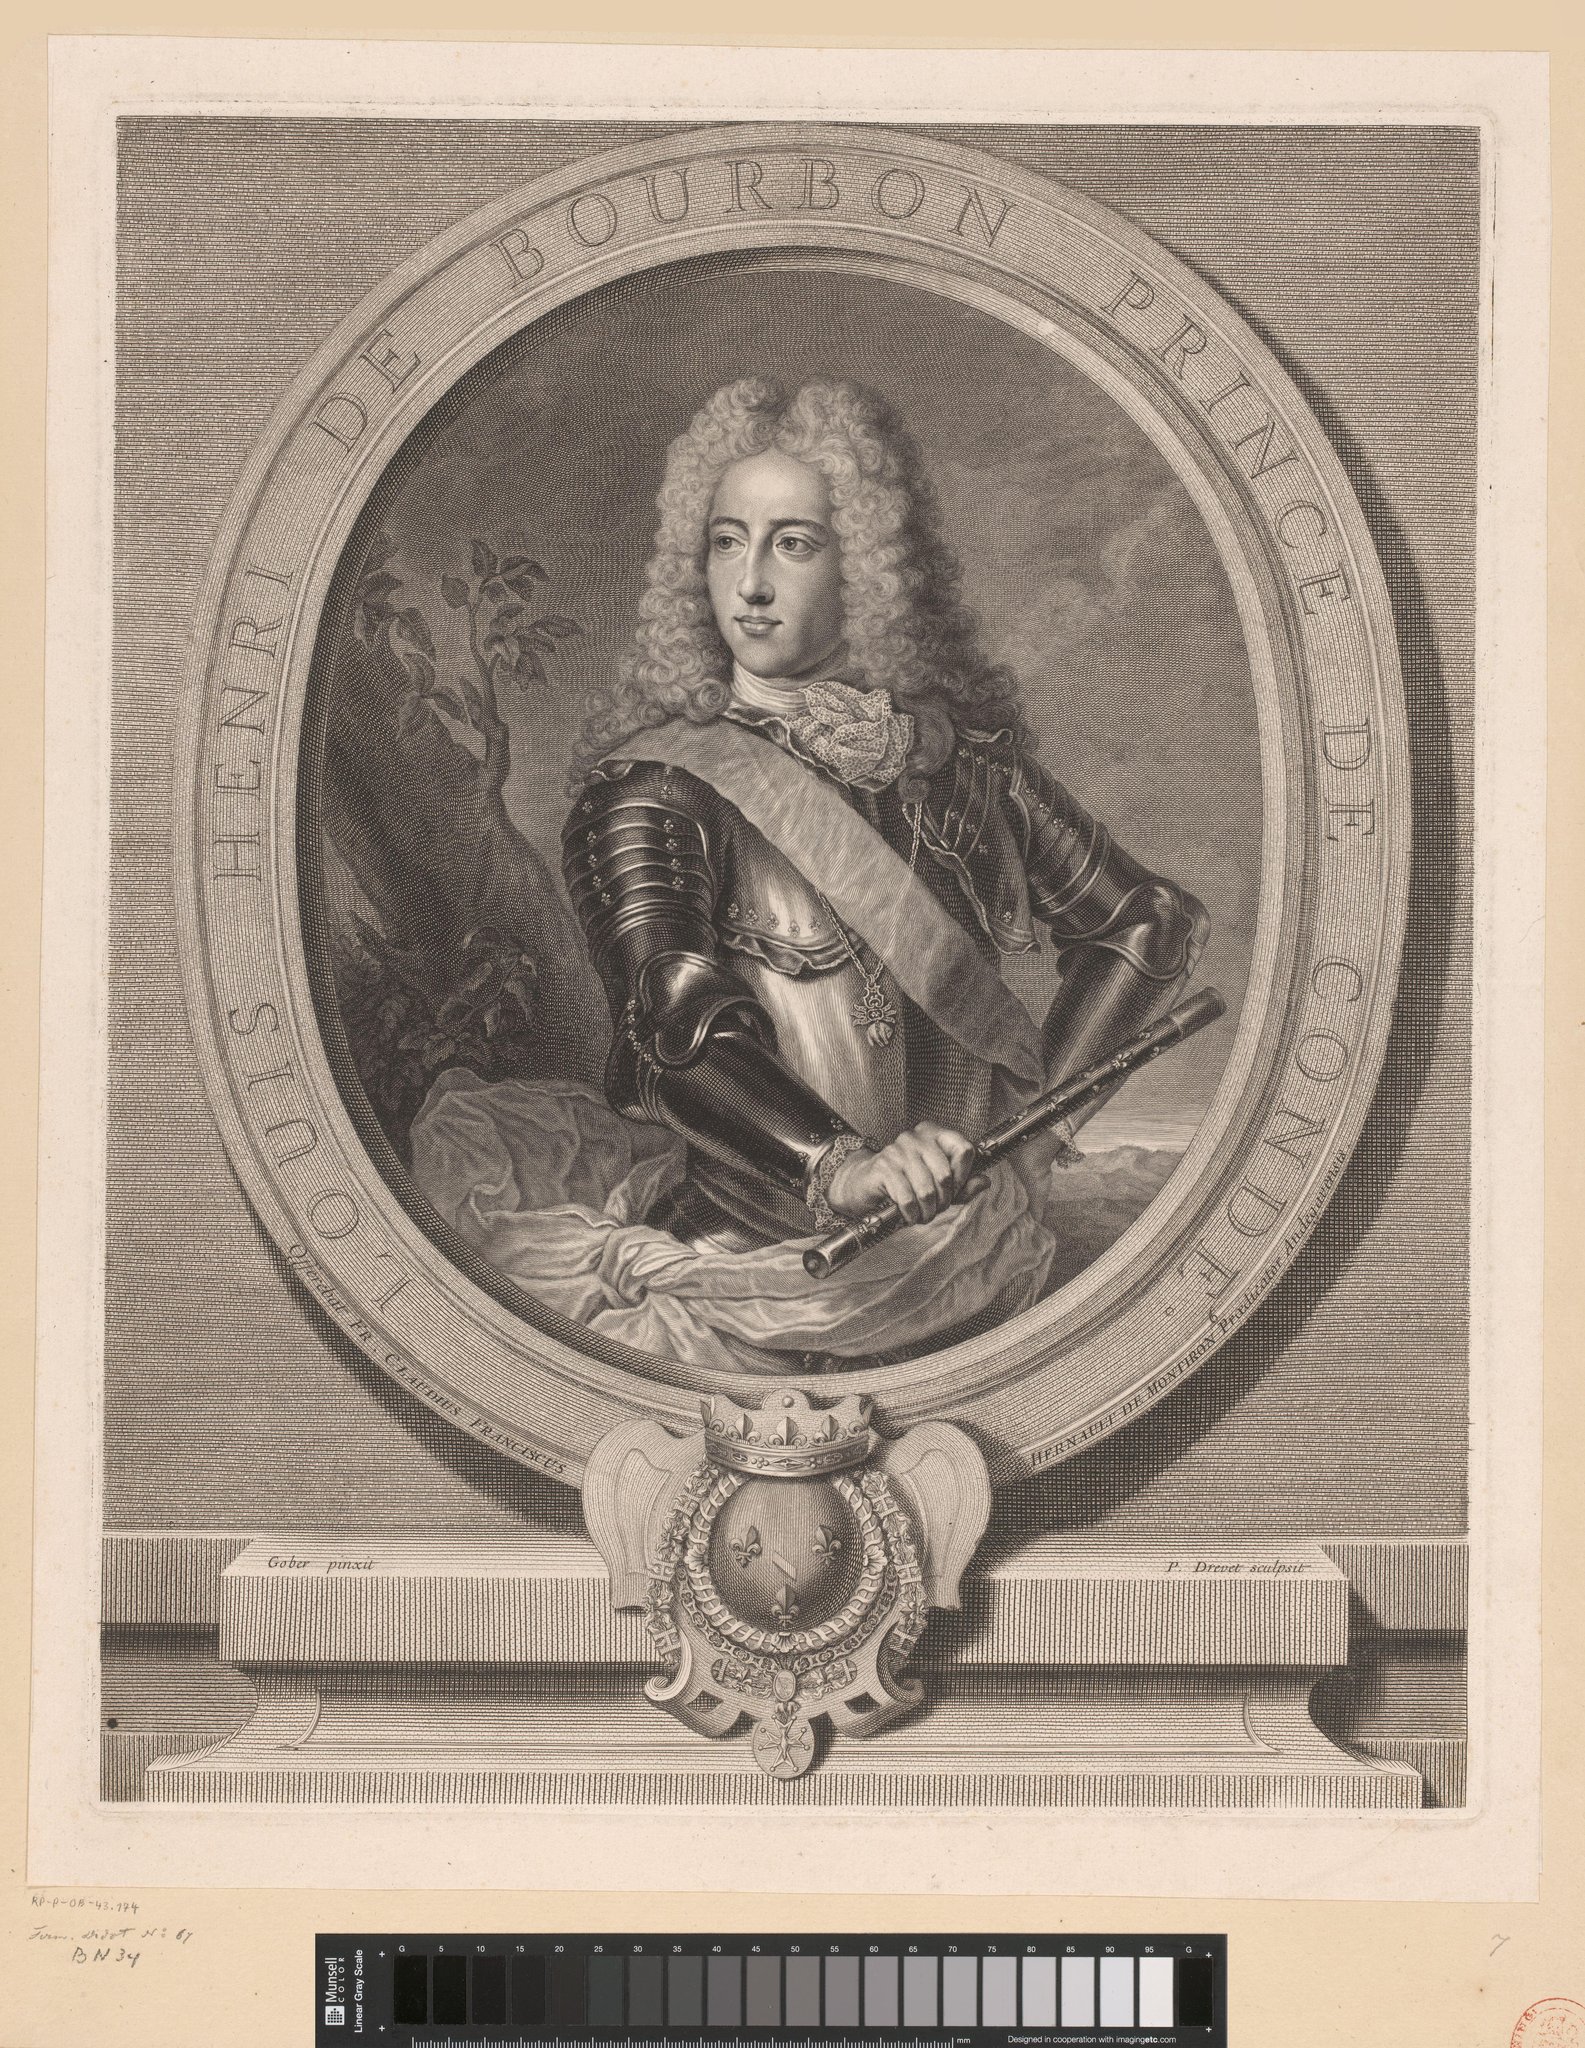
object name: print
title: Portret van Lodewijk IV van Bourbon-Condé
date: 1710-1738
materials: paper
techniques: engraving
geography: france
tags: paris, ornament ~ medallion, armour, historical persons, armorial bearing, heraldry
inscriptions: collector's mark: Lugt 240